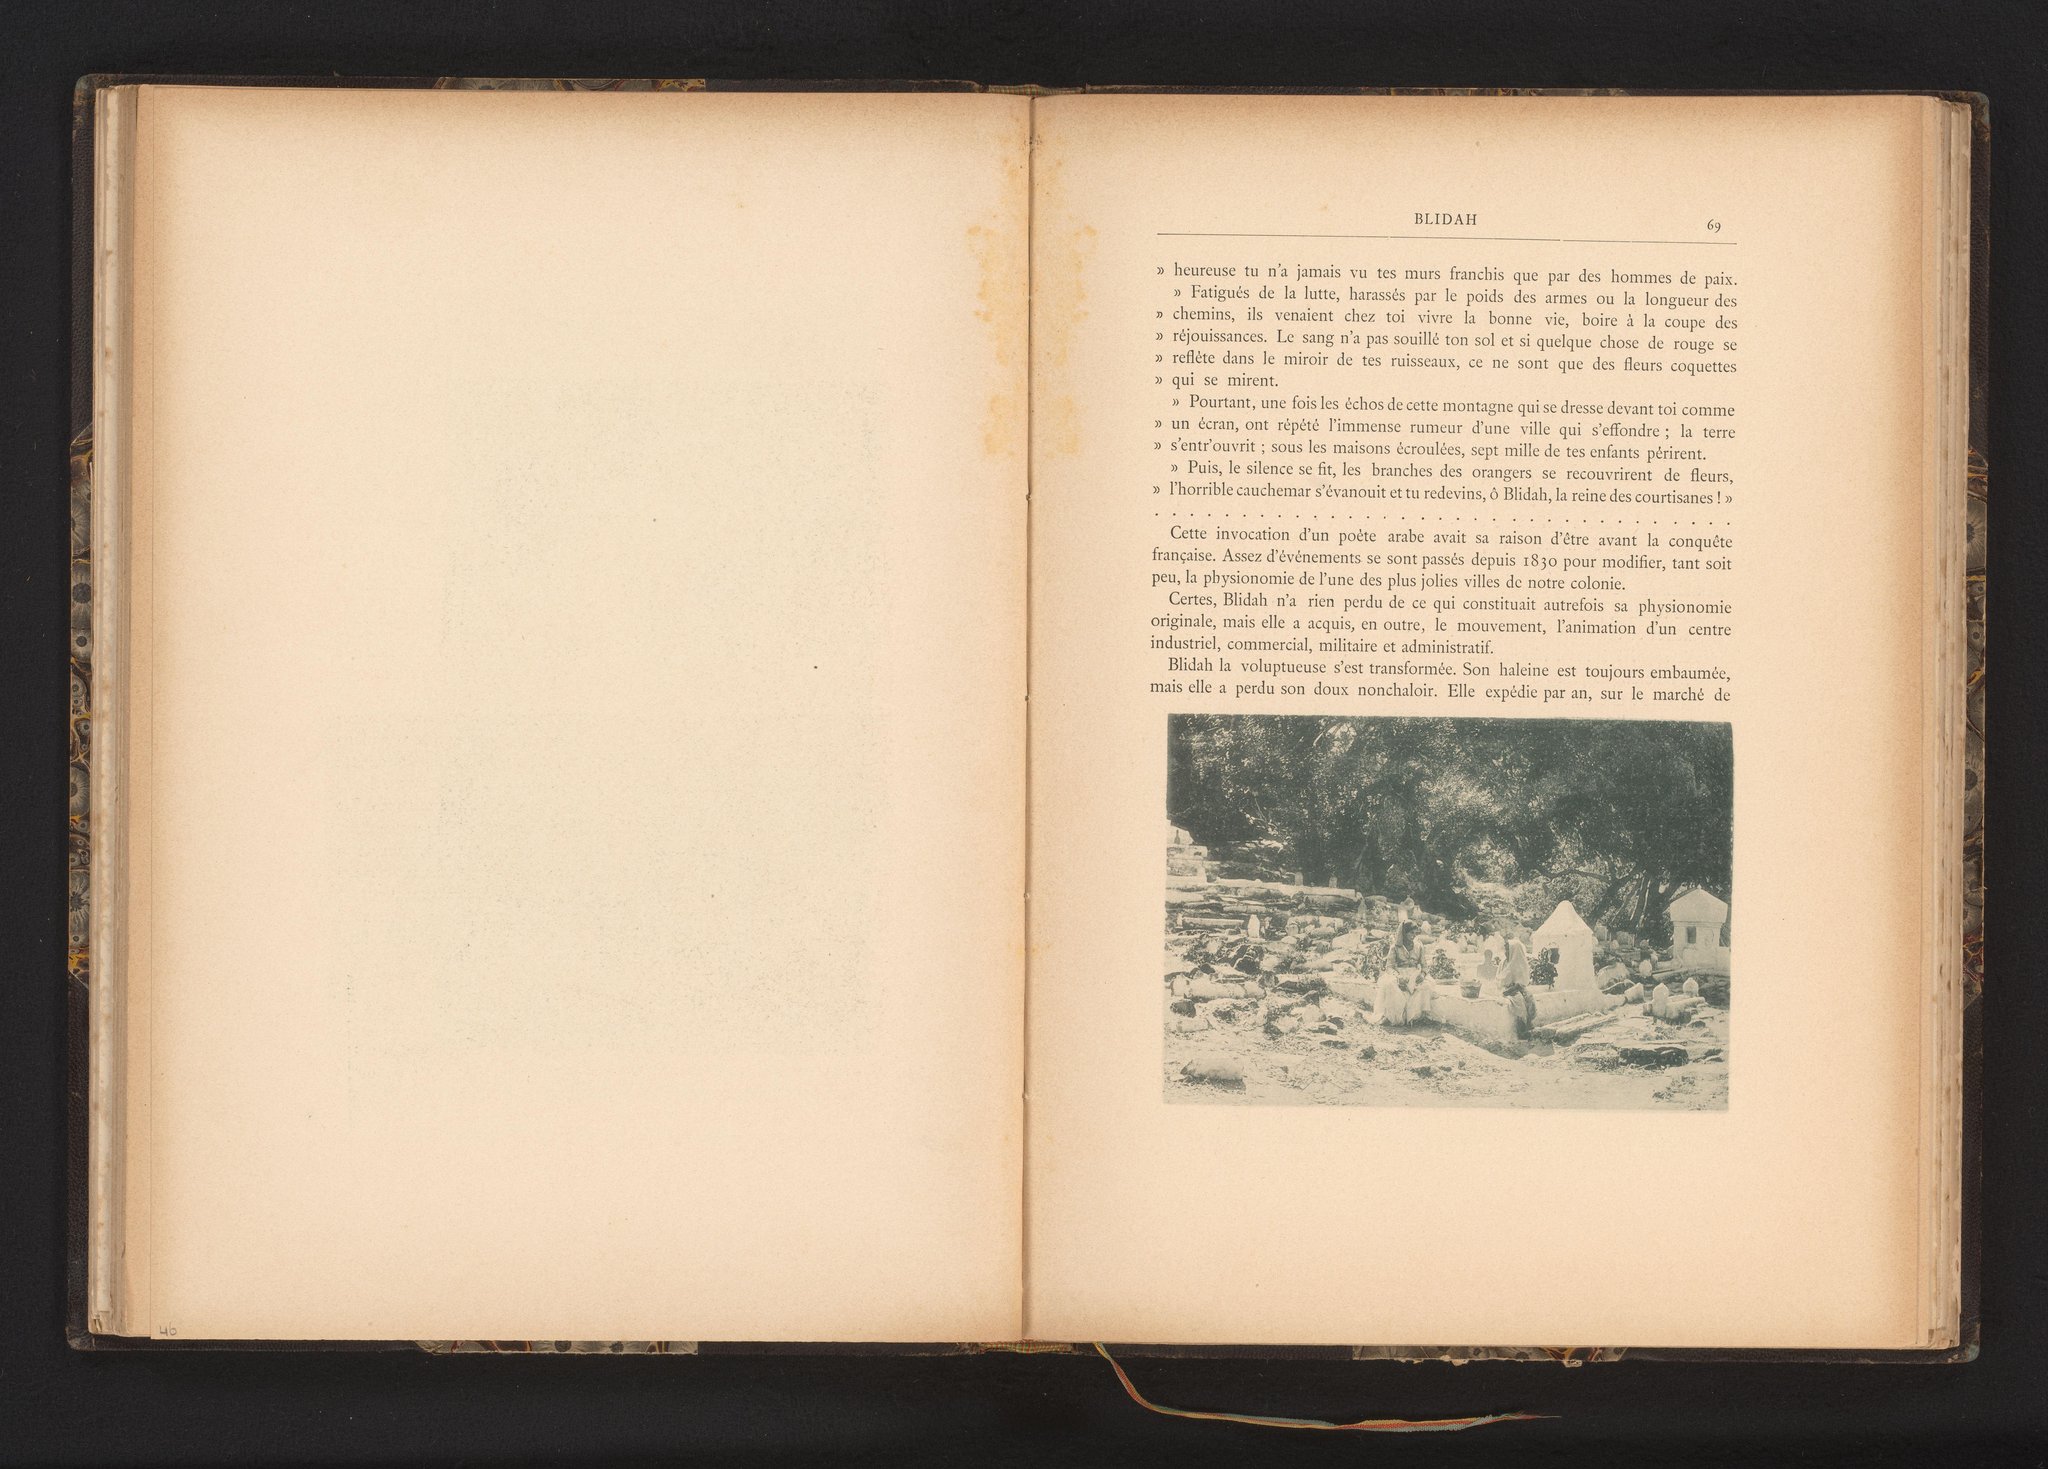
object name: photomechanical print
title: Vrouw en een kind zitten op een muurtje in El Boulaïda, Algerije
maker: jules gervais-courtellemont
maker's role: fotograaf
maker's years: 1863-1931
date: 1888-1893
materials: paper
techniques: photograph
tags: adult woman, child